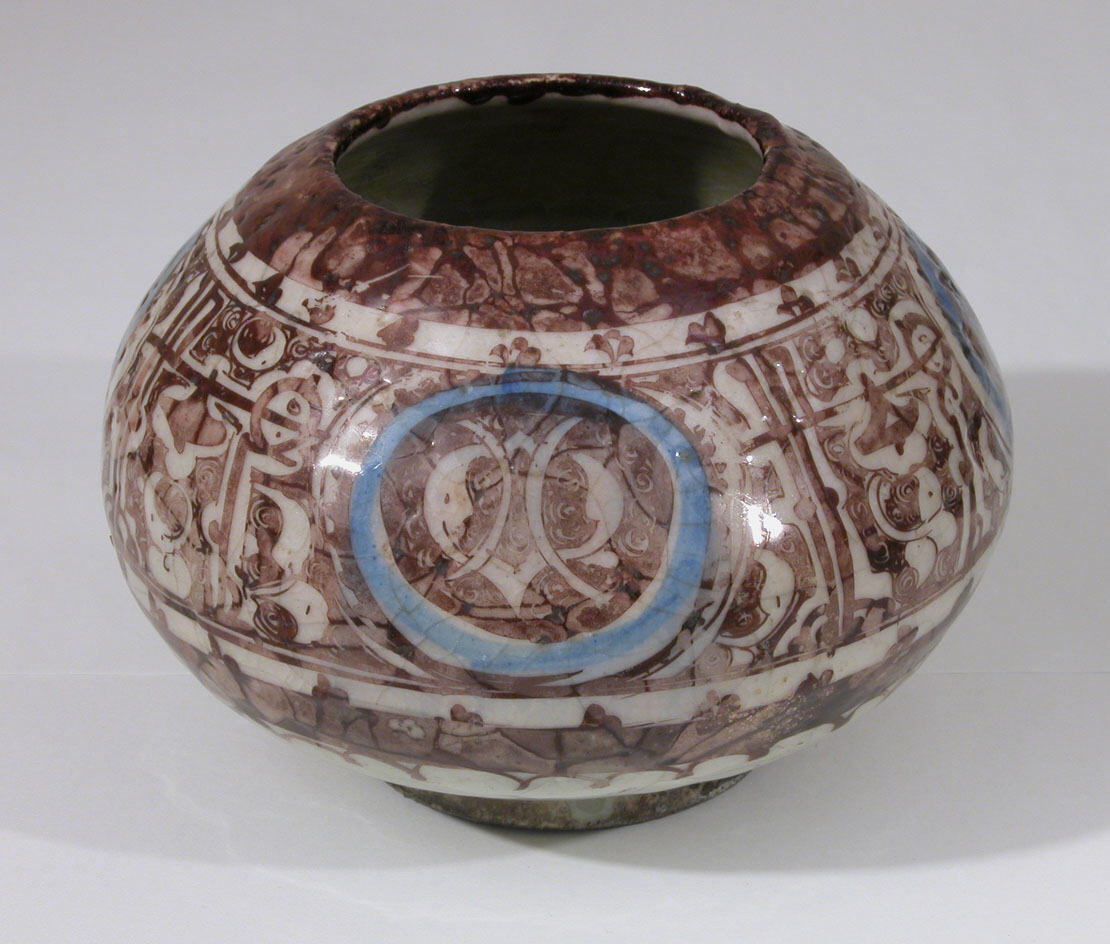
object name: bowl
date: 1101-1200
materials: glaze, stonepaste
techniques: painting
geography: syria